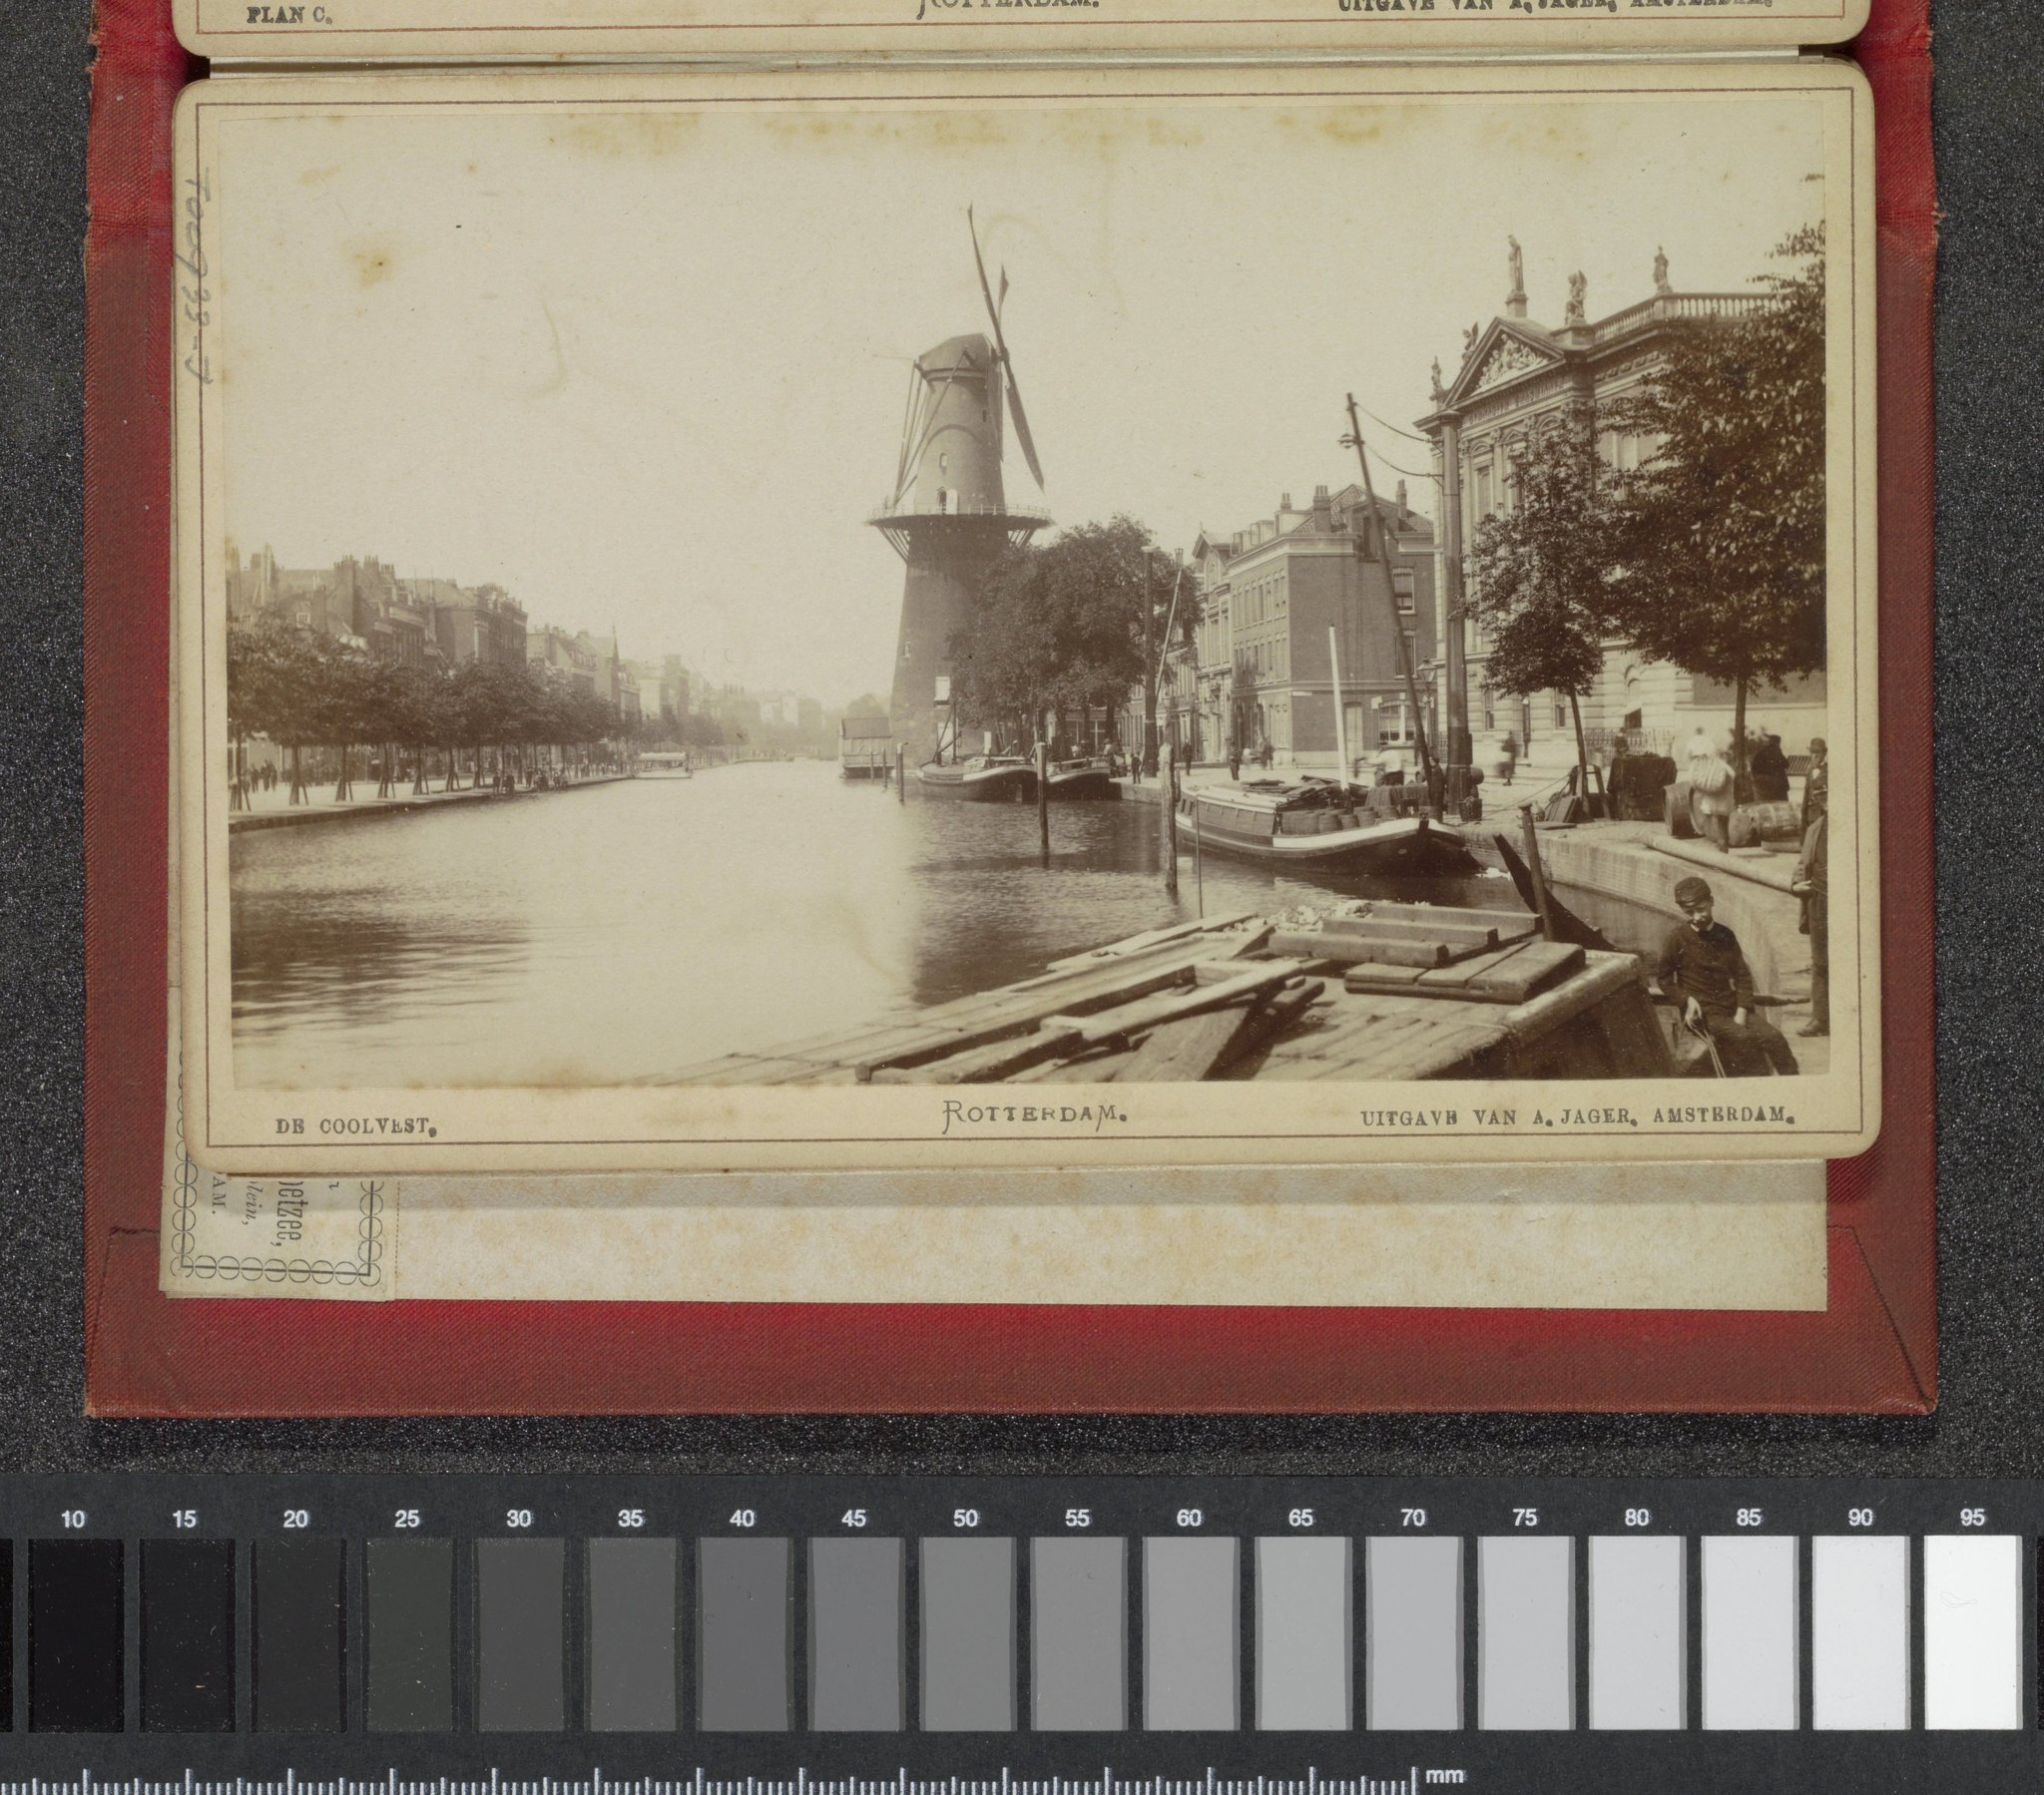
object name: photograph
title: Gezicht op de Coolvest te Rotterdam met in het midden windmolen De Hoop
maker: andries jager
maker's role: publisher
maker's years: 1825-1905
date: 1860-1900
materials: cardboard, photographic support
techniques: albumen print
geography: rotterdam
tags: windmill, rotterdam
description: Onderdeel van Leporelloalbum met foto's van Rotterdam.